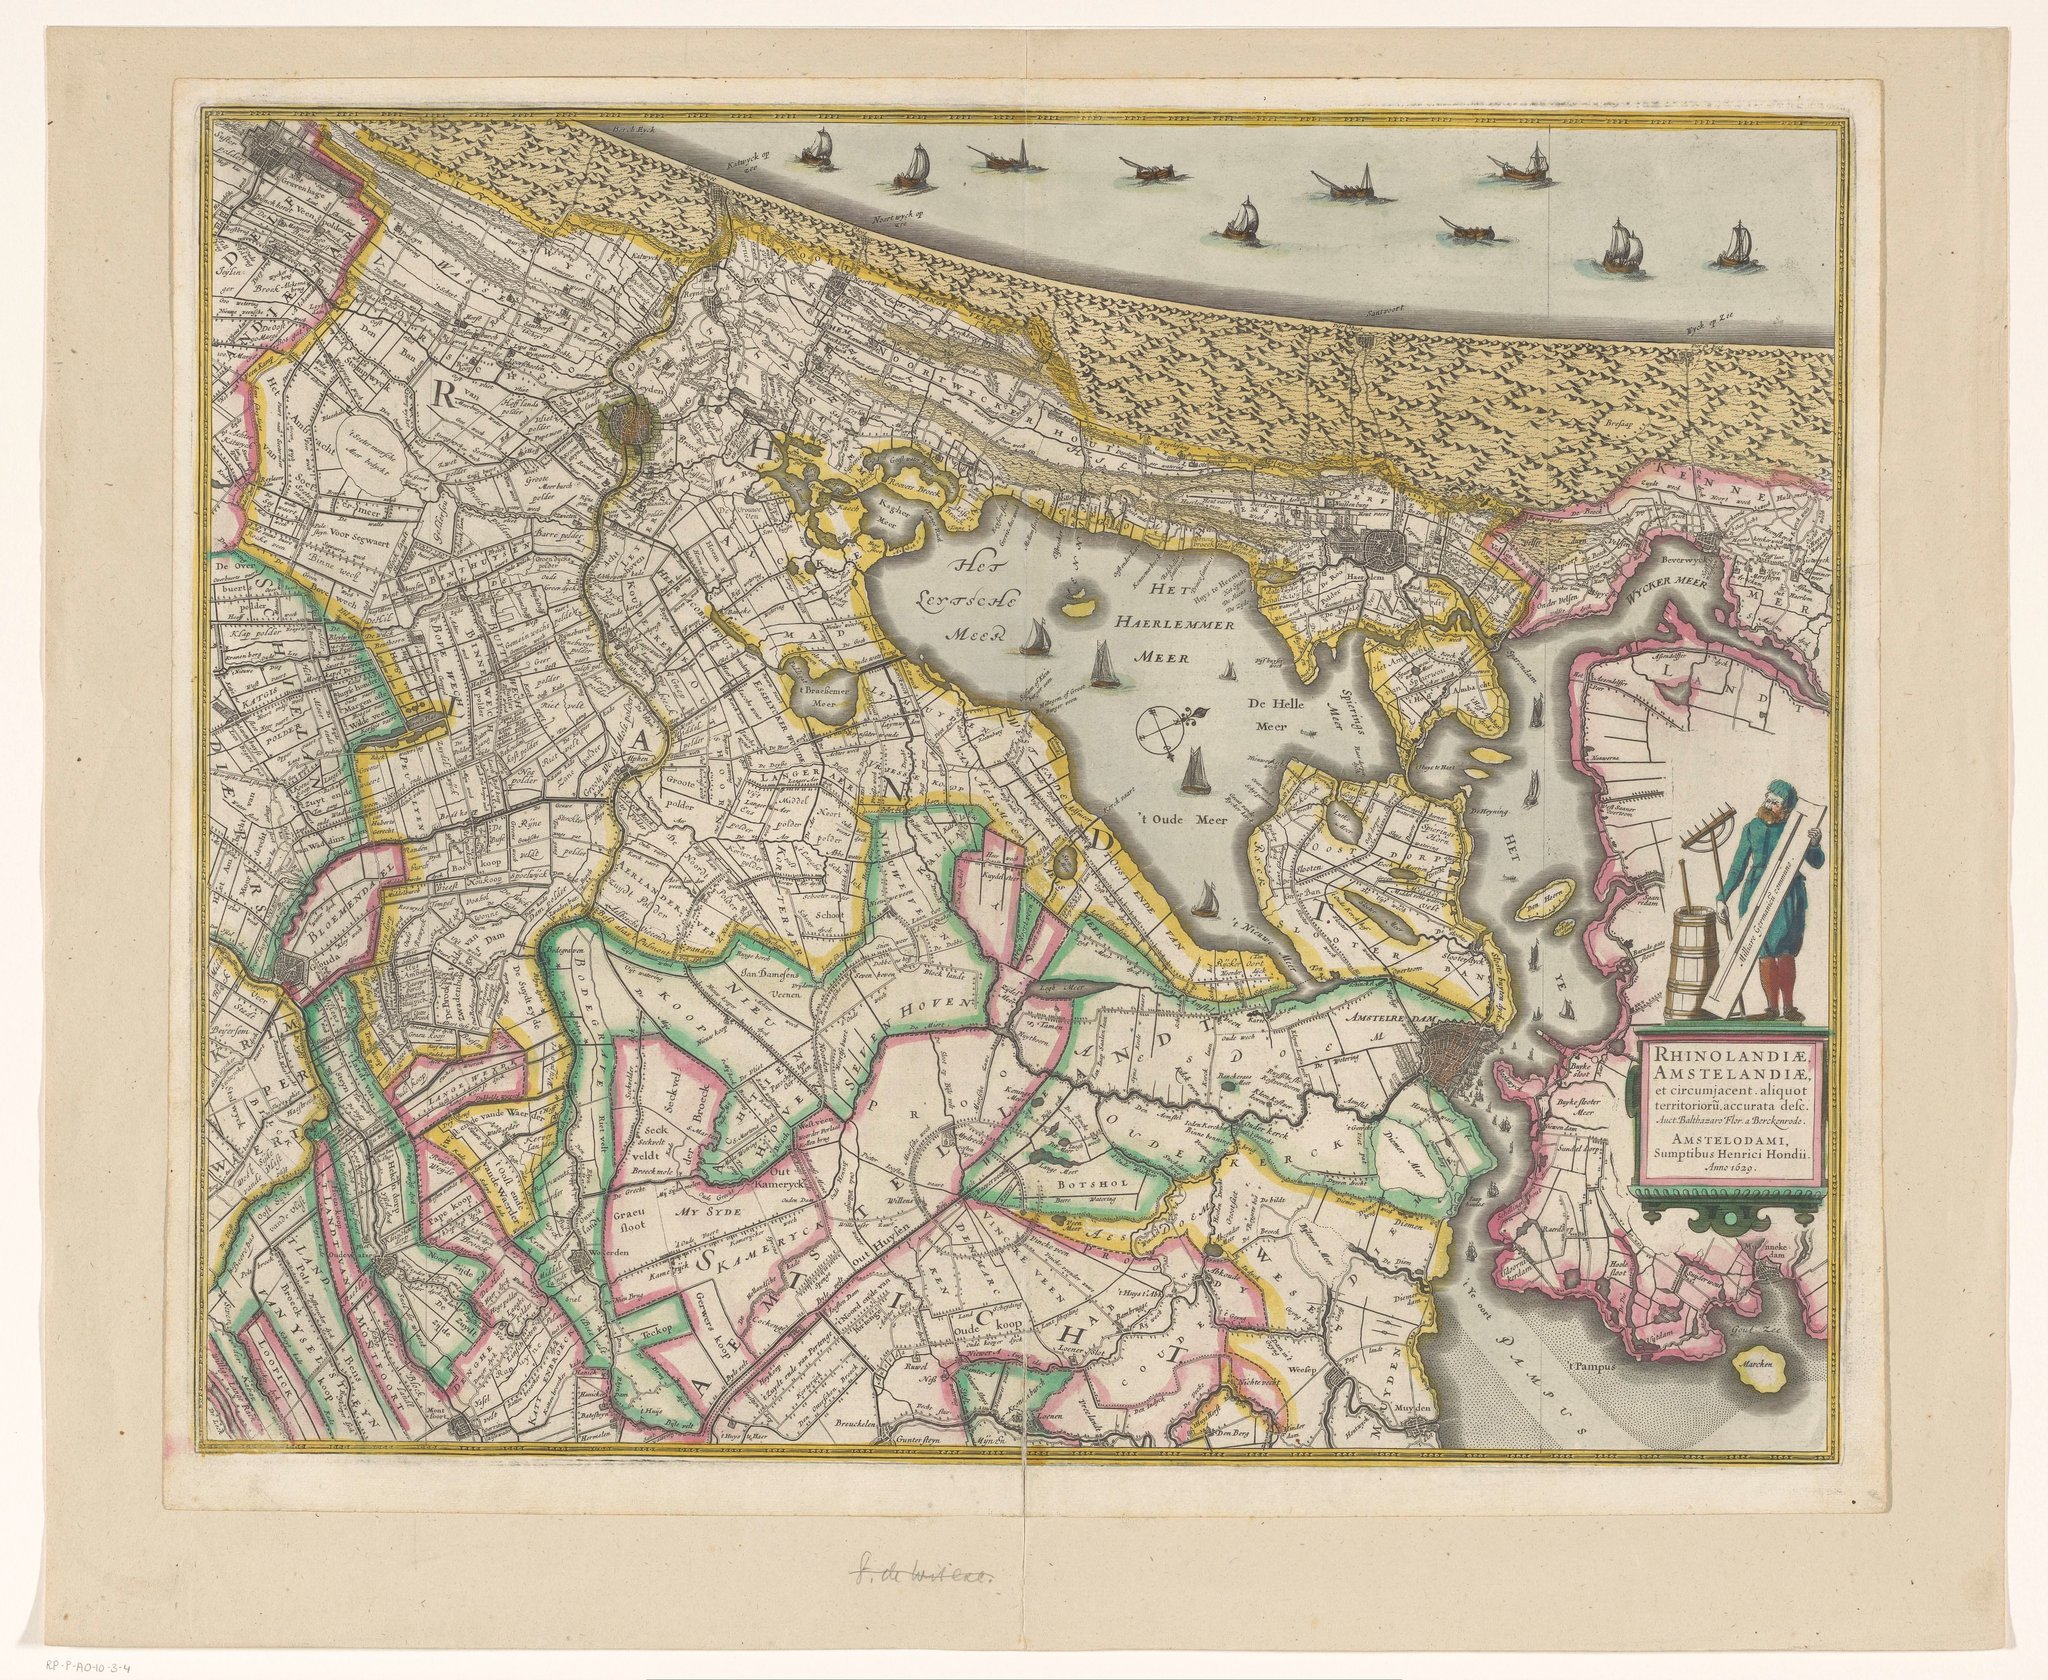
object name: map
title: Rhinolandiae, Amstelandiae, et circumjacent. aliquot territorioru …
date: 1629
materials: paper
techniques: engraving, etching, hand coloring, letterpress printing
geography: amsterdam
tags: maps of separate countries or regions, agricultural implements: rake, holland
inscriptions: collector's mark: Lugt 2228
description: Prent gebruikt in: Mercator, Gerard en Jodocus Hondius. Atlas ou representation du monde universel, et des parties d’icelui (…). 2 delen. Amsterdam: Henricus Hondius, 1633, dl. 1. Of in: Mercator, Gerard en Jodocus Hondius. L'appendice de l'atlas de Gerard Mercator et Iudocus Hondius: contenant diverses nouvelles tables et descriptions (…). Amsterdam: Henricus Hondius, 1633.